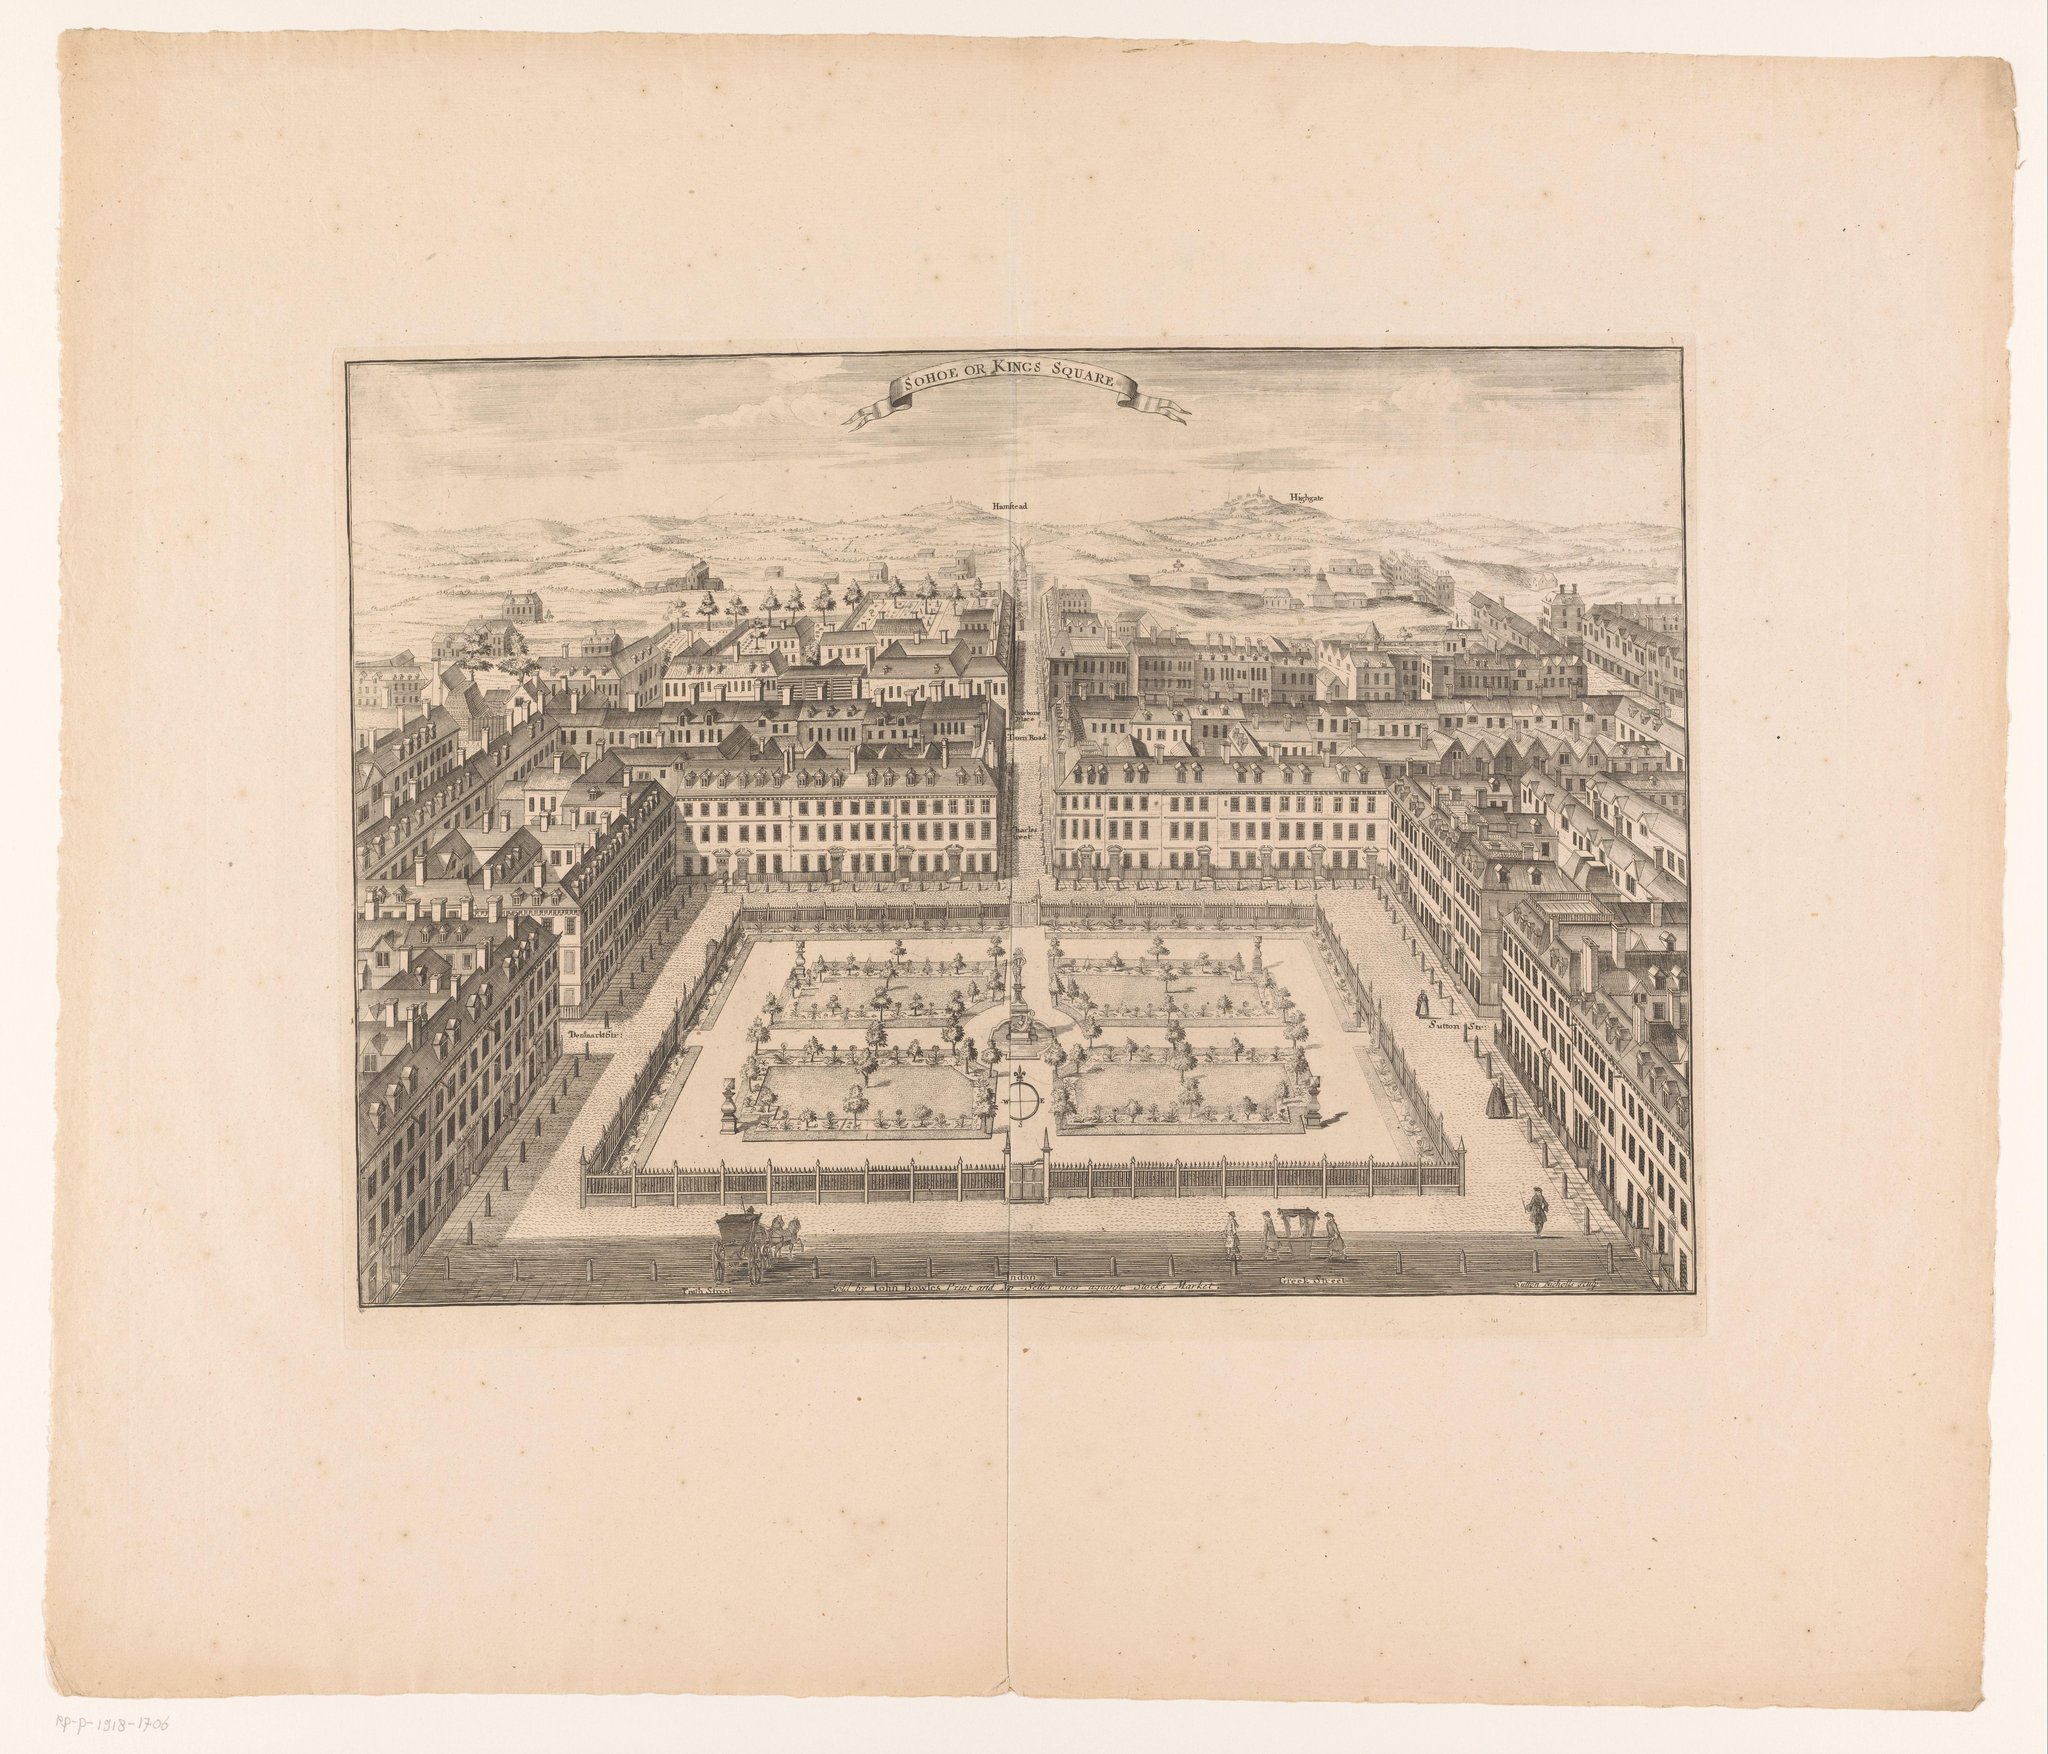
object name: print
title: Sohoe or Kings Square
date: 1720-1731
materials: paper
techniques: engraving, etching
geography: london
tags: square, place, circus, etc.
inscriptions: collector's mark: Lugt 2233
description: Deze reeks werd voor het eerst compleet uitgegeven in 1731, al zijn de losse prenten al voor die tijd uitgebracht. De meeste prenten zijn vervaardigd door Sutton Nicholls. De serie werd aangeboden voor verkoop door John Bowles in zijn catalogus 1753, op pagina 76, nummer 16. De originele naam van het plein was 'King's Square' (als eerbetoon aan Karel II, koning van Engeland), maar werd in 1746 ook op kaarten aangeduid als 'Soho Square'.